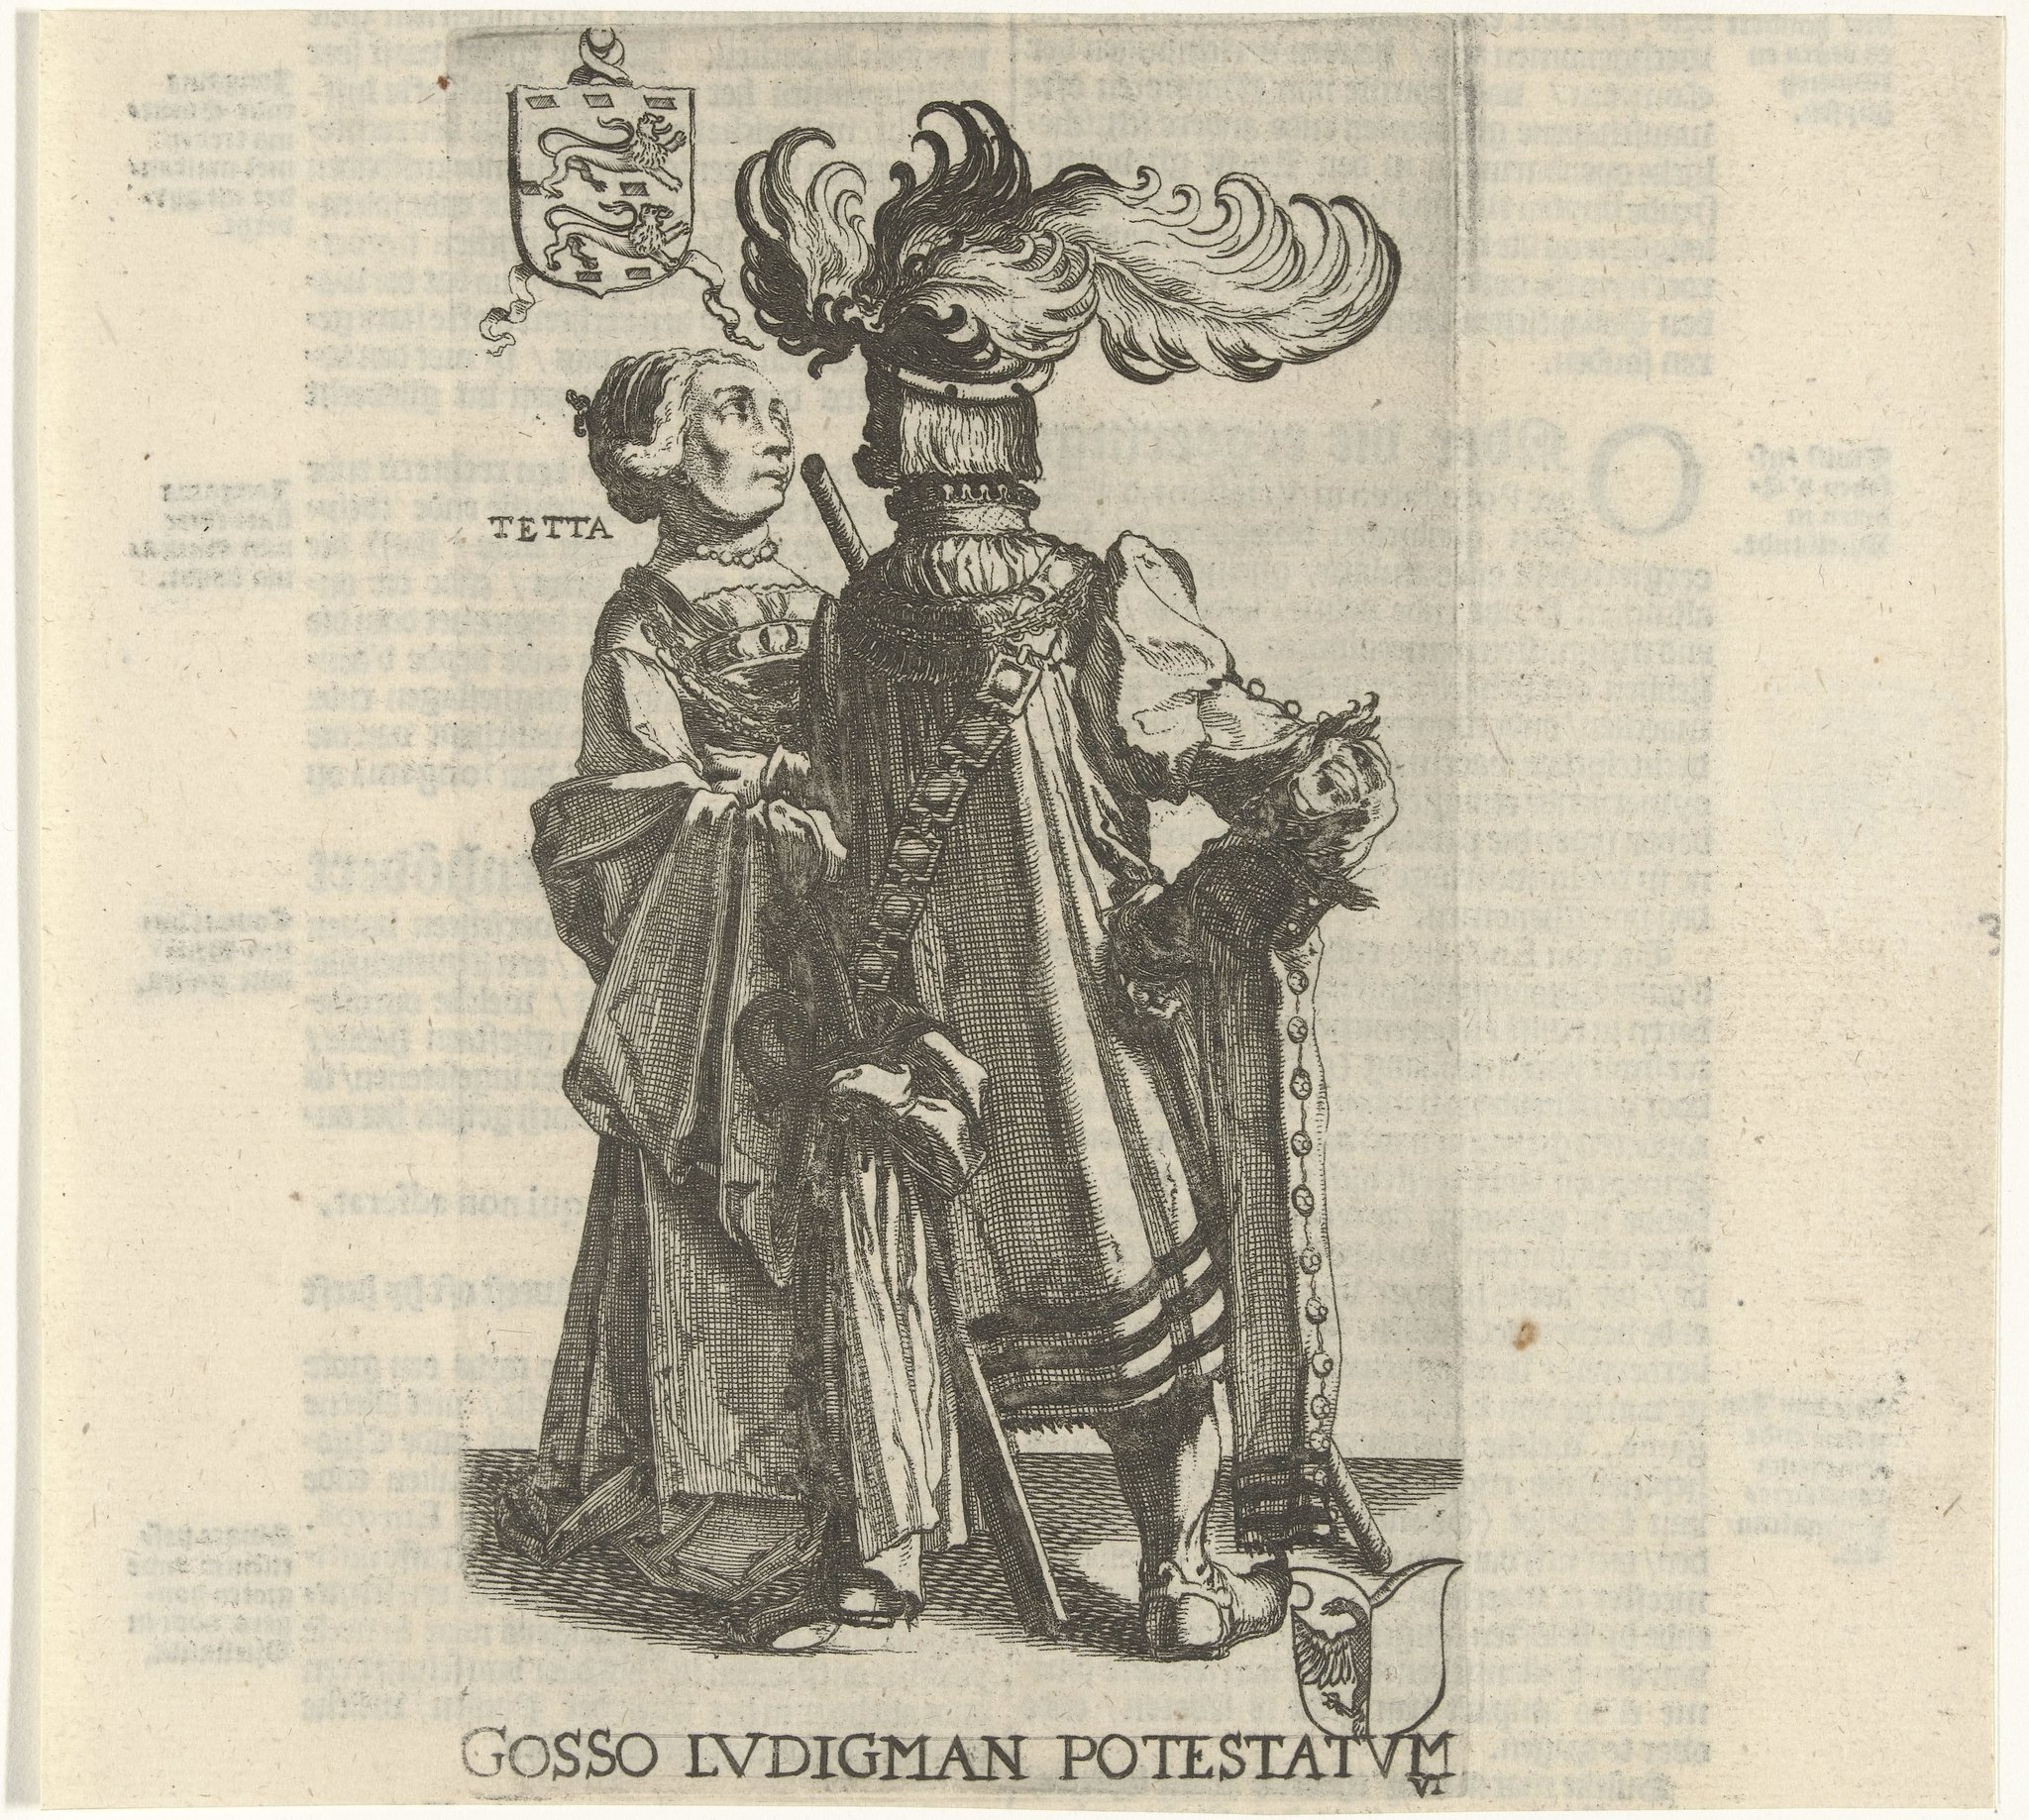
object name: print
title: Friese heersers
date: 1622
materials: paper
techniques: etching, letterpress printing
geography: northern netherlands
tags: gosso ludigman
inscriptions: collector's mark: Lugt 2228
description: De prent is ook als boekillustratie gebruikt in: Winsemius, P.W. Chronique ofte Historische geschiedenisse van Vrieslant (...). Franeker: Joannes Lamrinck, 1622.